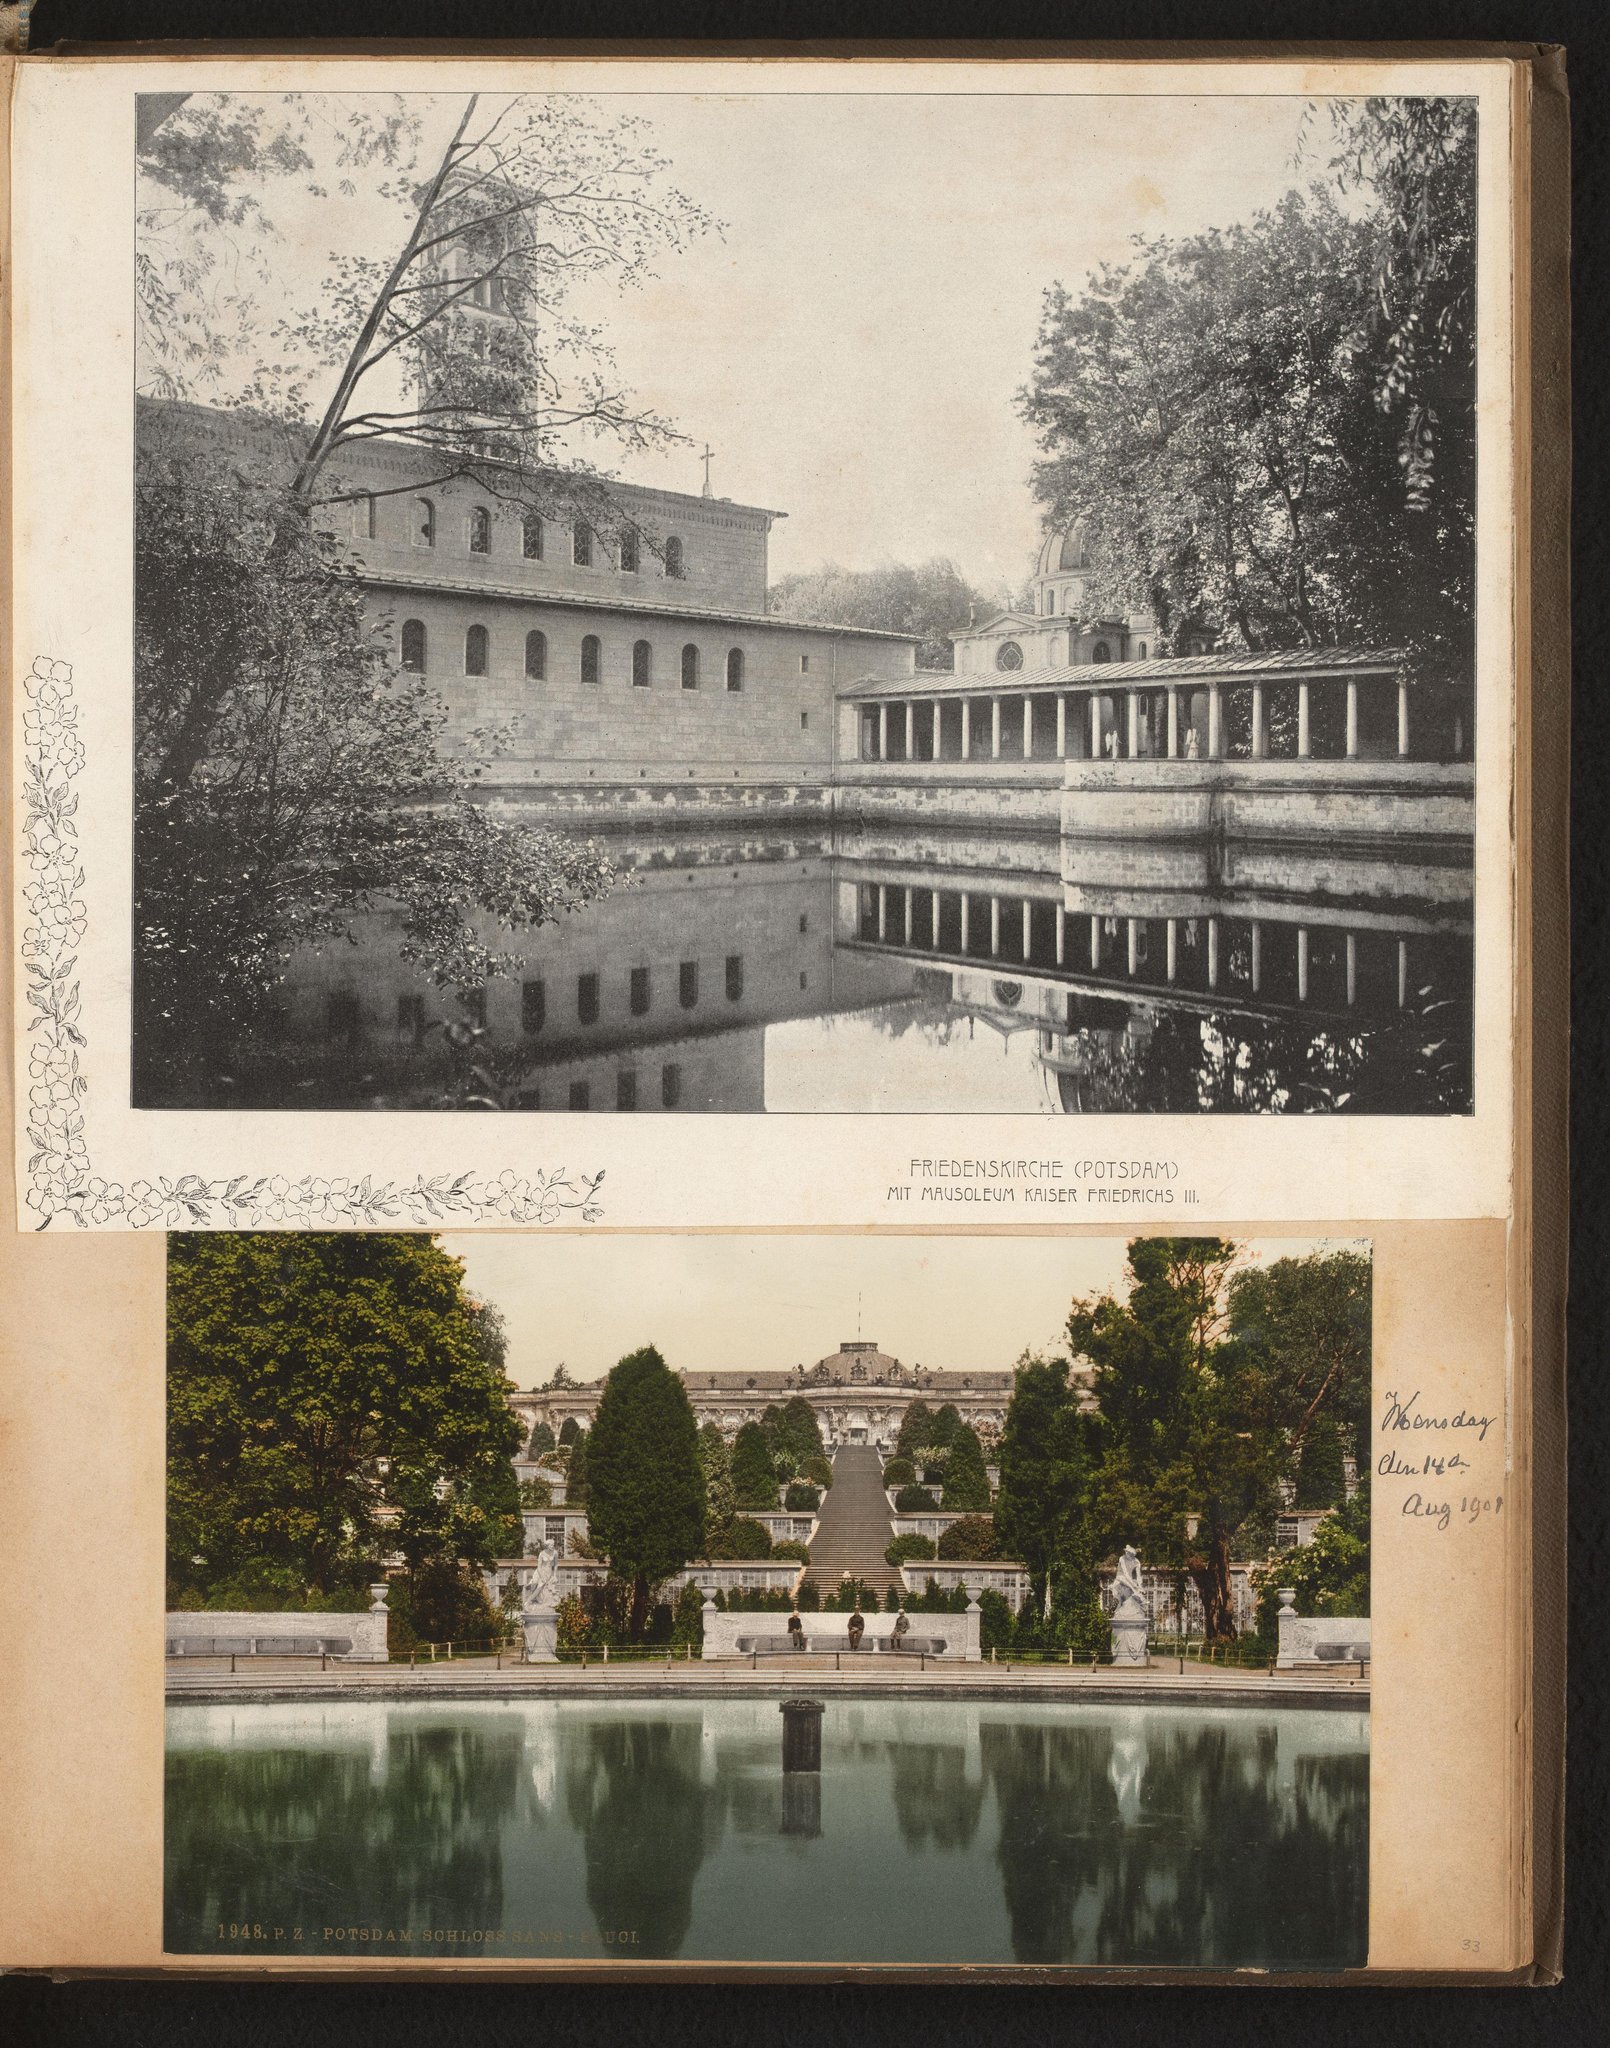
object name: photomechanical print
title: Friedenskirche en Schloss Sanssouci, Potsdam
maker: Anonymous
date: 1896-1901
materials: paper, photographic process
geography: zurich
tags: palace, french or architectonic garden; formal garden, church (exterior)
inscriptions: title: ‘1948. P.Z.- Potsdam. Schloss Sans-Souci.’, inscription: ‘Woensdag/ den 14de/ Aug 1901’, title: ‘Friedenskirche (Potsdam)/ mit Mausoleum Kaiser Friedrichs III.’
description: Deze fotomechanische afdrukken maken deel uit van een album.